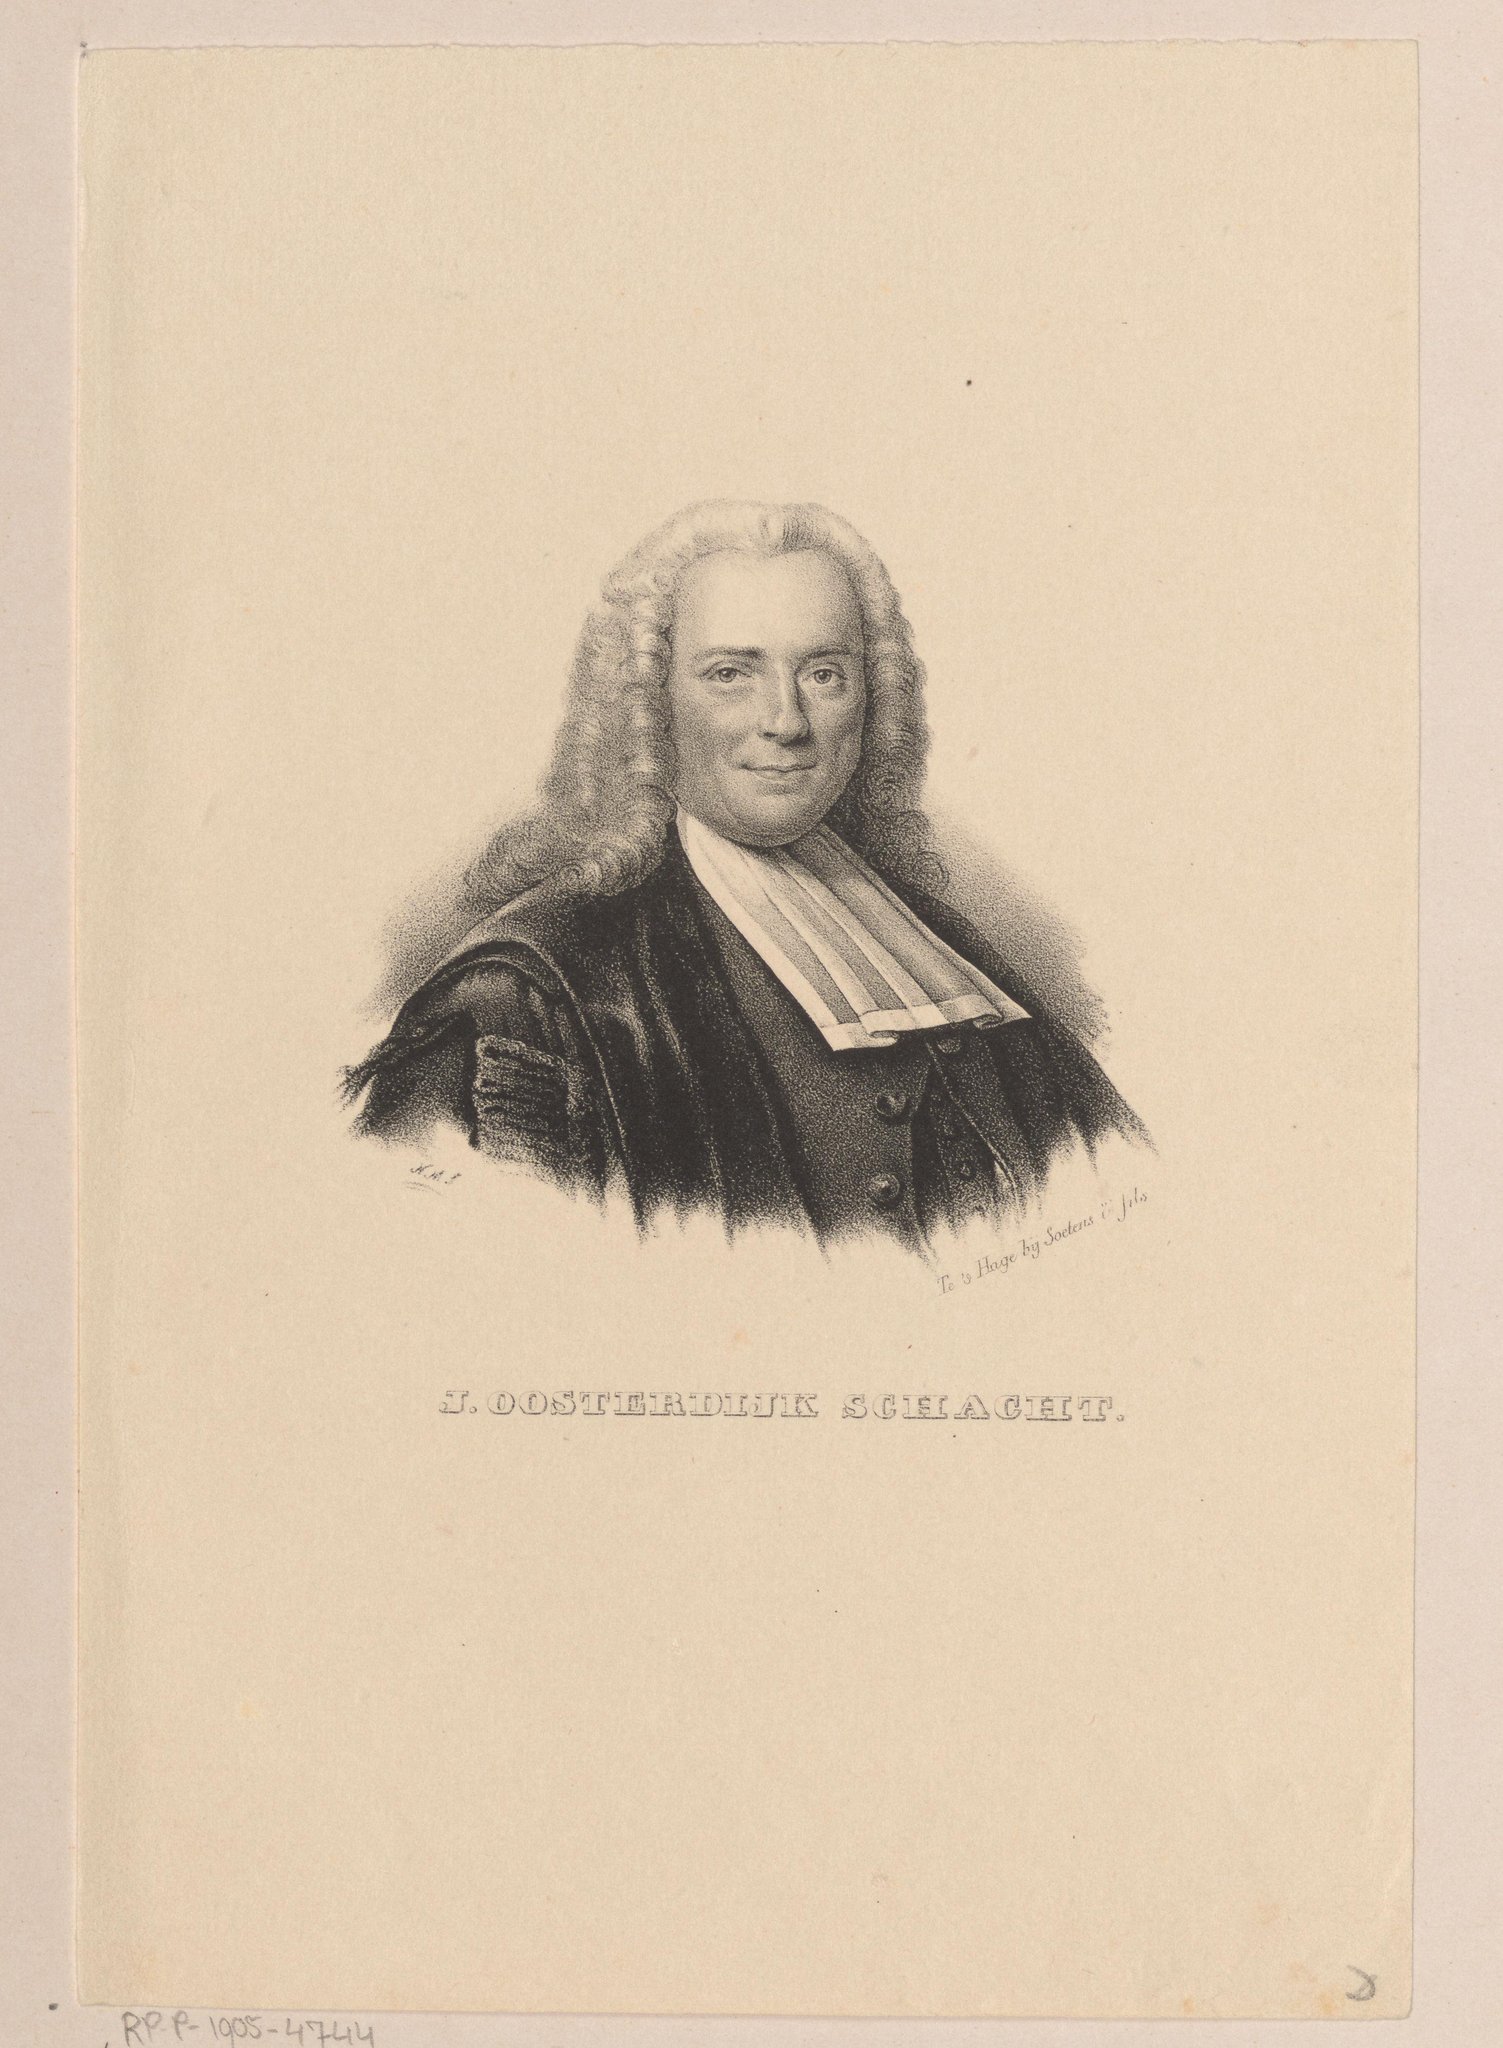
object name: print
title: Portret van Johannes Oosterdijk Schacht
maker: nicolaas martinus schild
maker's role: draughtsman, print maker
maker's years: 1822-1840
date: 1837-1840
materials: paper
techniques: lithograph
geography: the hague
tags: leiden, historical persons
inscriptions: collector's mark: Lugt 2228